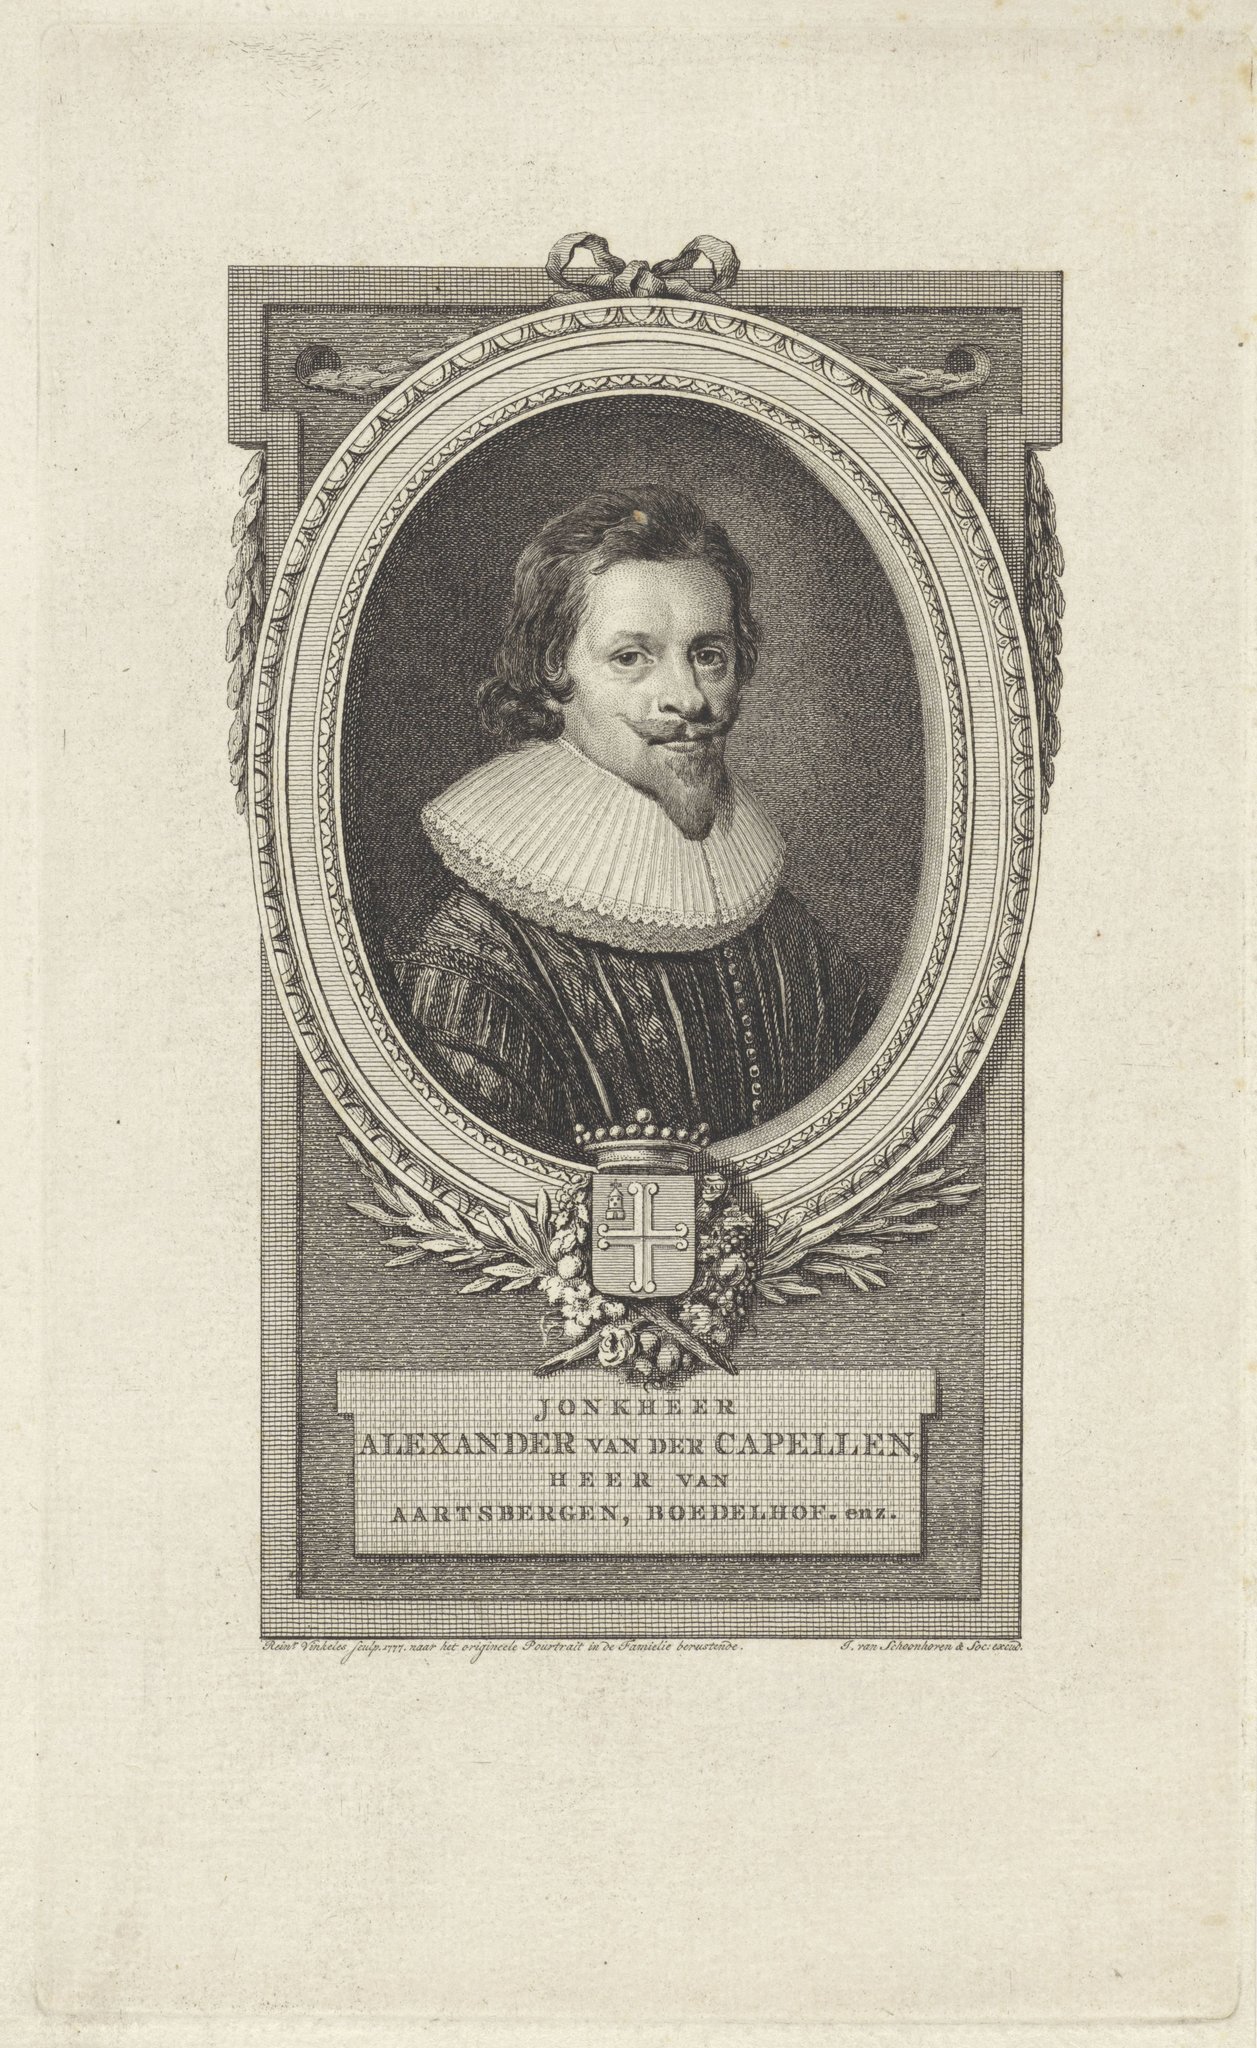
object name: print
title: Portret van Alexander van der Capellen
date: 1777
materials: paper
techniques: engraving, etching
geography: utrecht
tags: dordrecht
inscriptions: collector's mark: Lugt 2228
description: Portret van de staatsman Alexander van der Capellen, heer van Aartsbergen.